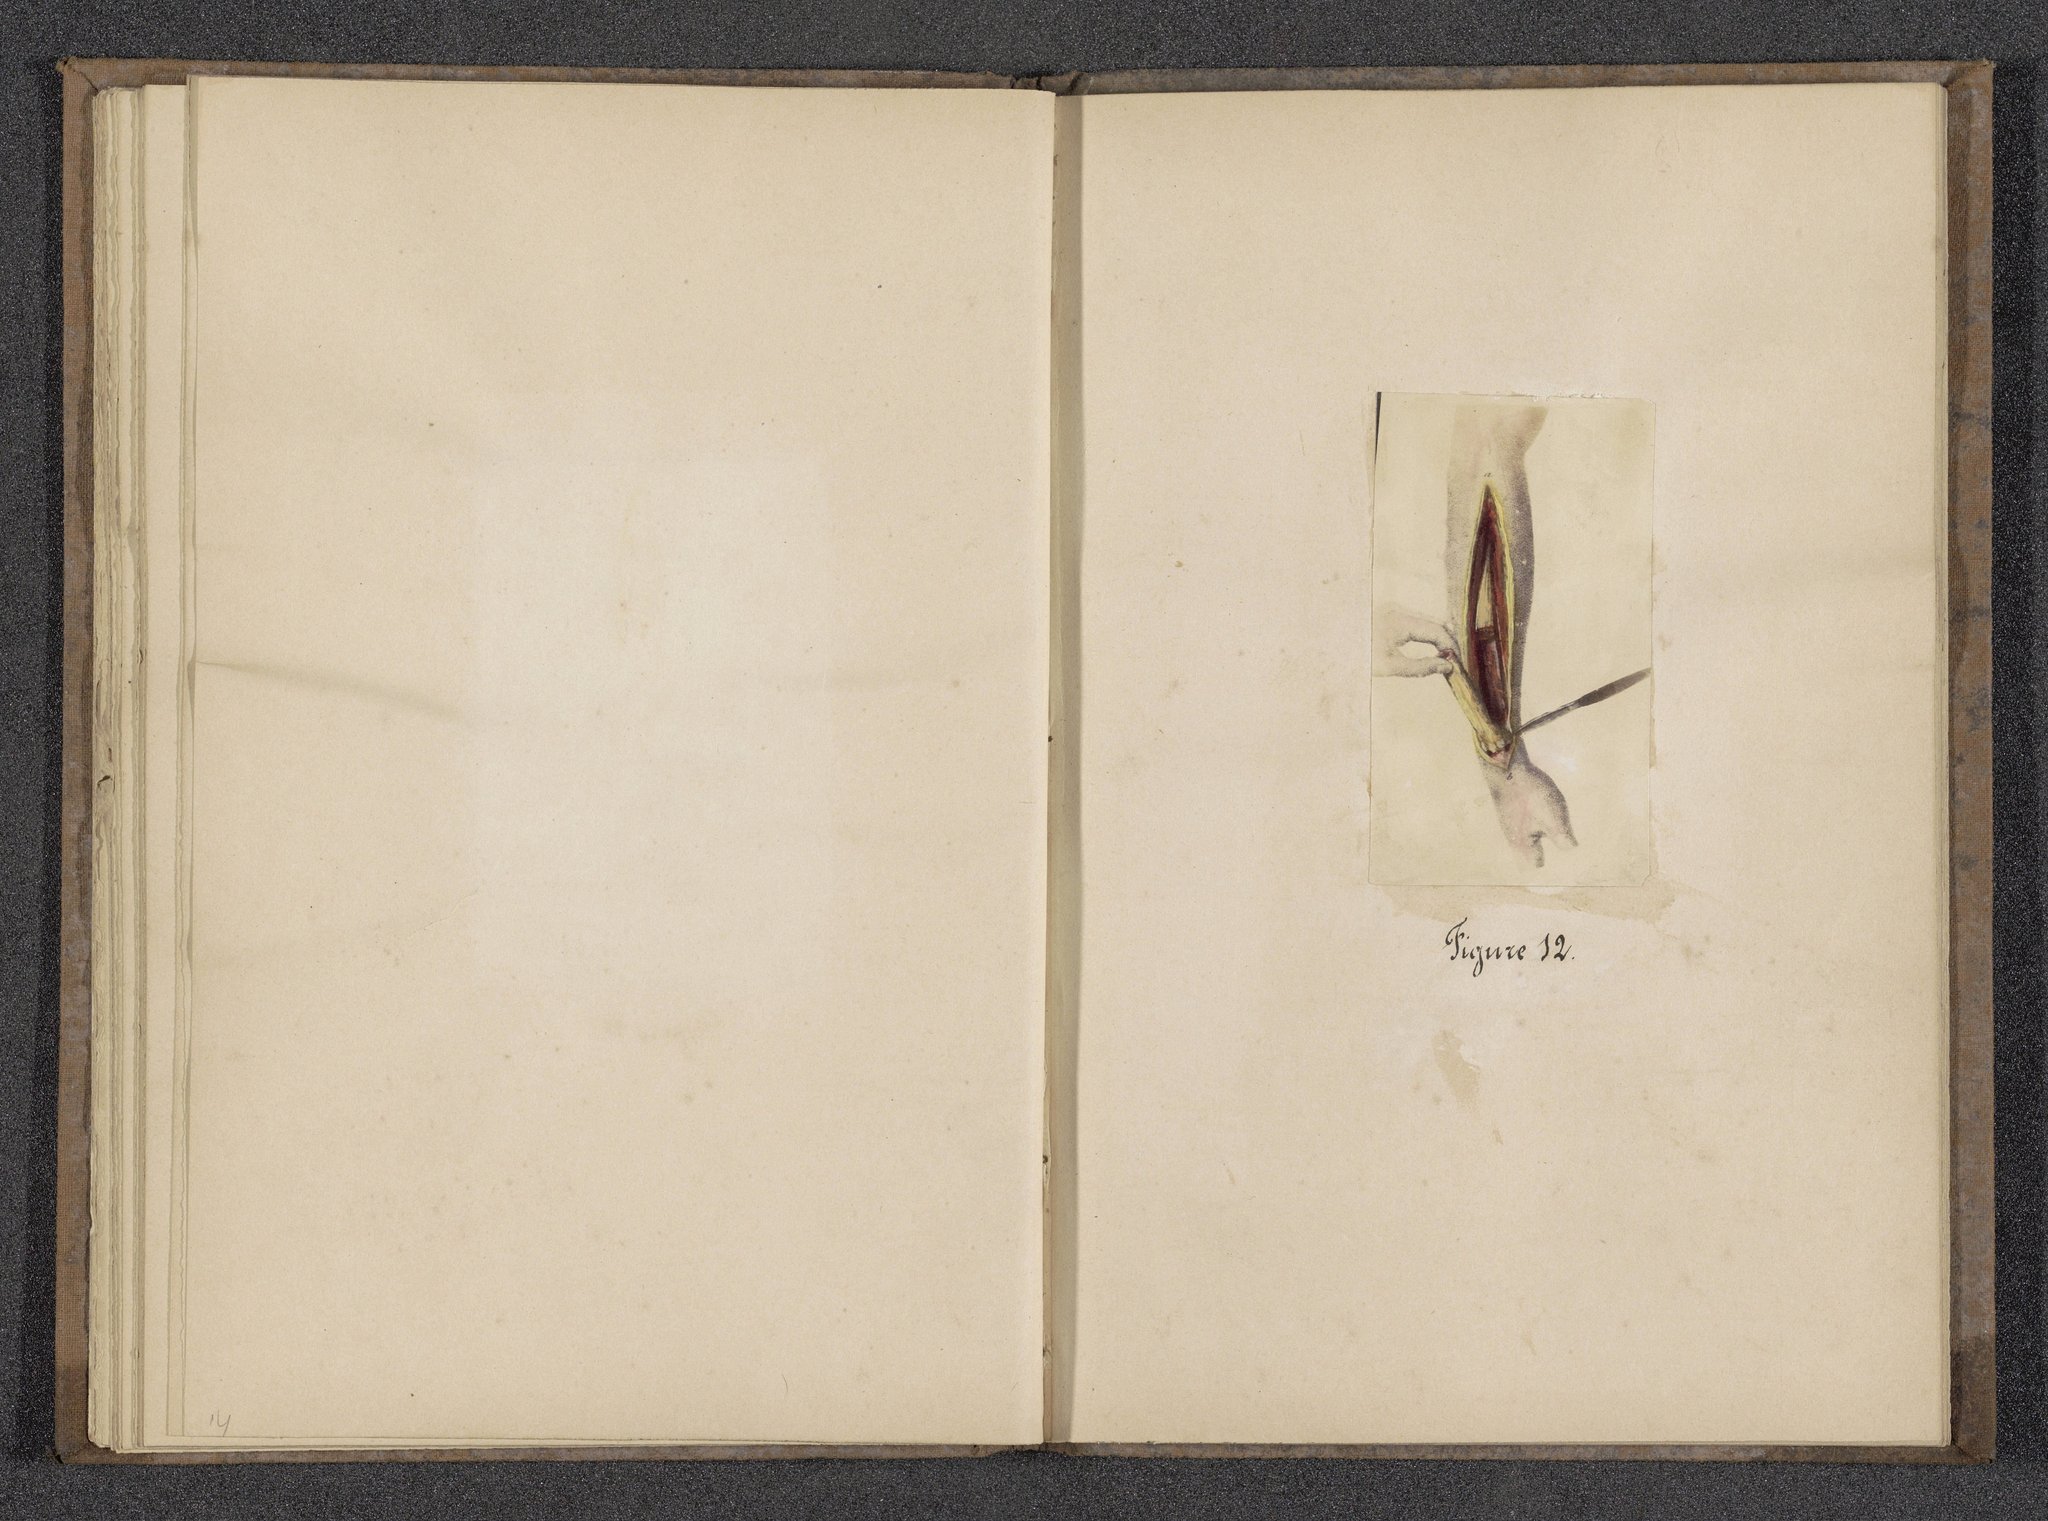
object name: page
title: Fotoreproductie van een schematische tekening, voorstellende een operatie aan een onderarm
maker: Anonymous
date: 1878-1880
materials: photographic support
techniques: albumen print, hand coloring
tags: operation, surgery, bones of the arms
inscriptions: number: ‘Figure 12.’